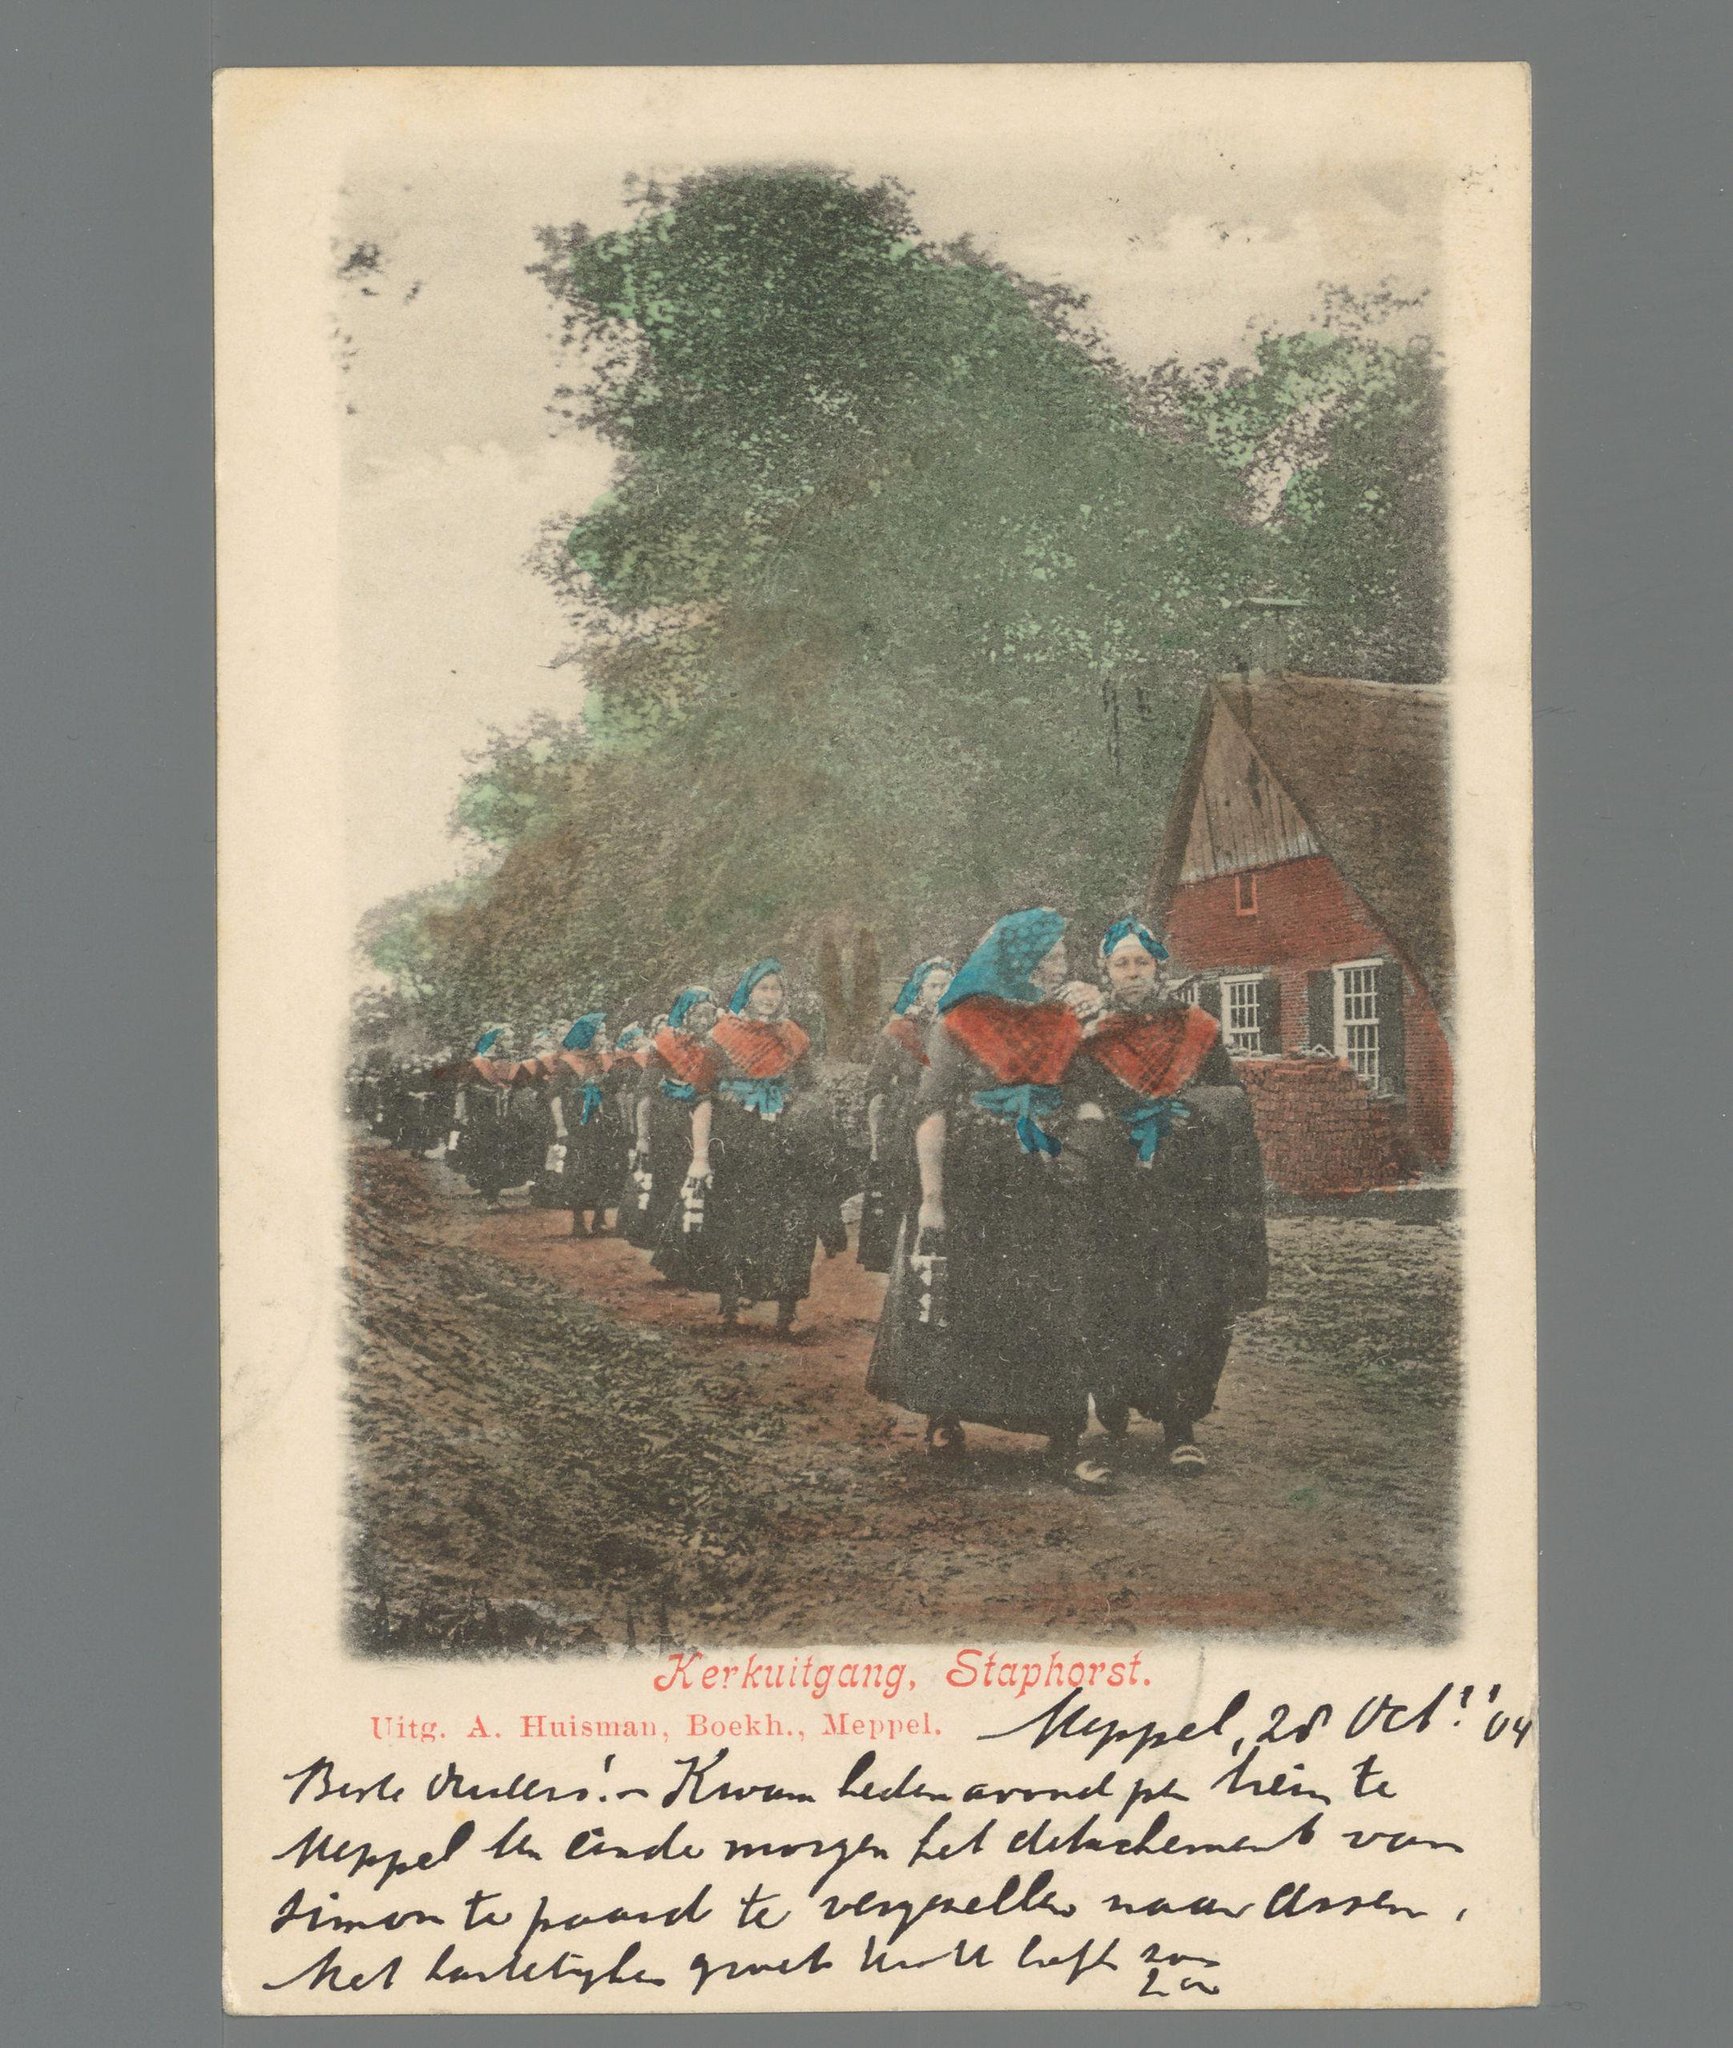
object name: photomechanical print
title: Kerkuitgang, Staphorst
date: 1897-1905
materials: cardboard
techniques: photograph, hand coloring, writing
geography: staphorst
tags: leaving the church after service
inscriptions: postage stamp